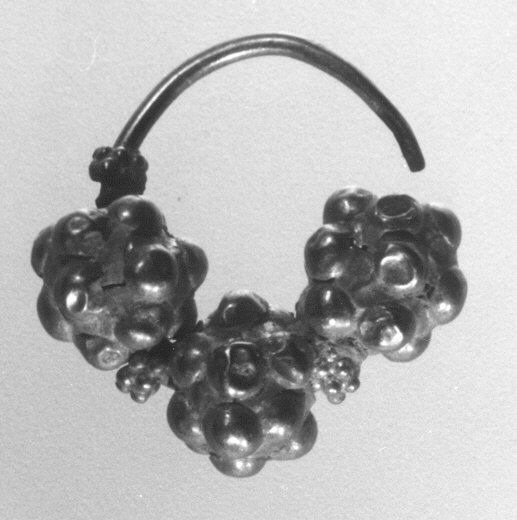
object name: earring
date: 1001-1300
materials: gold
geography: iran